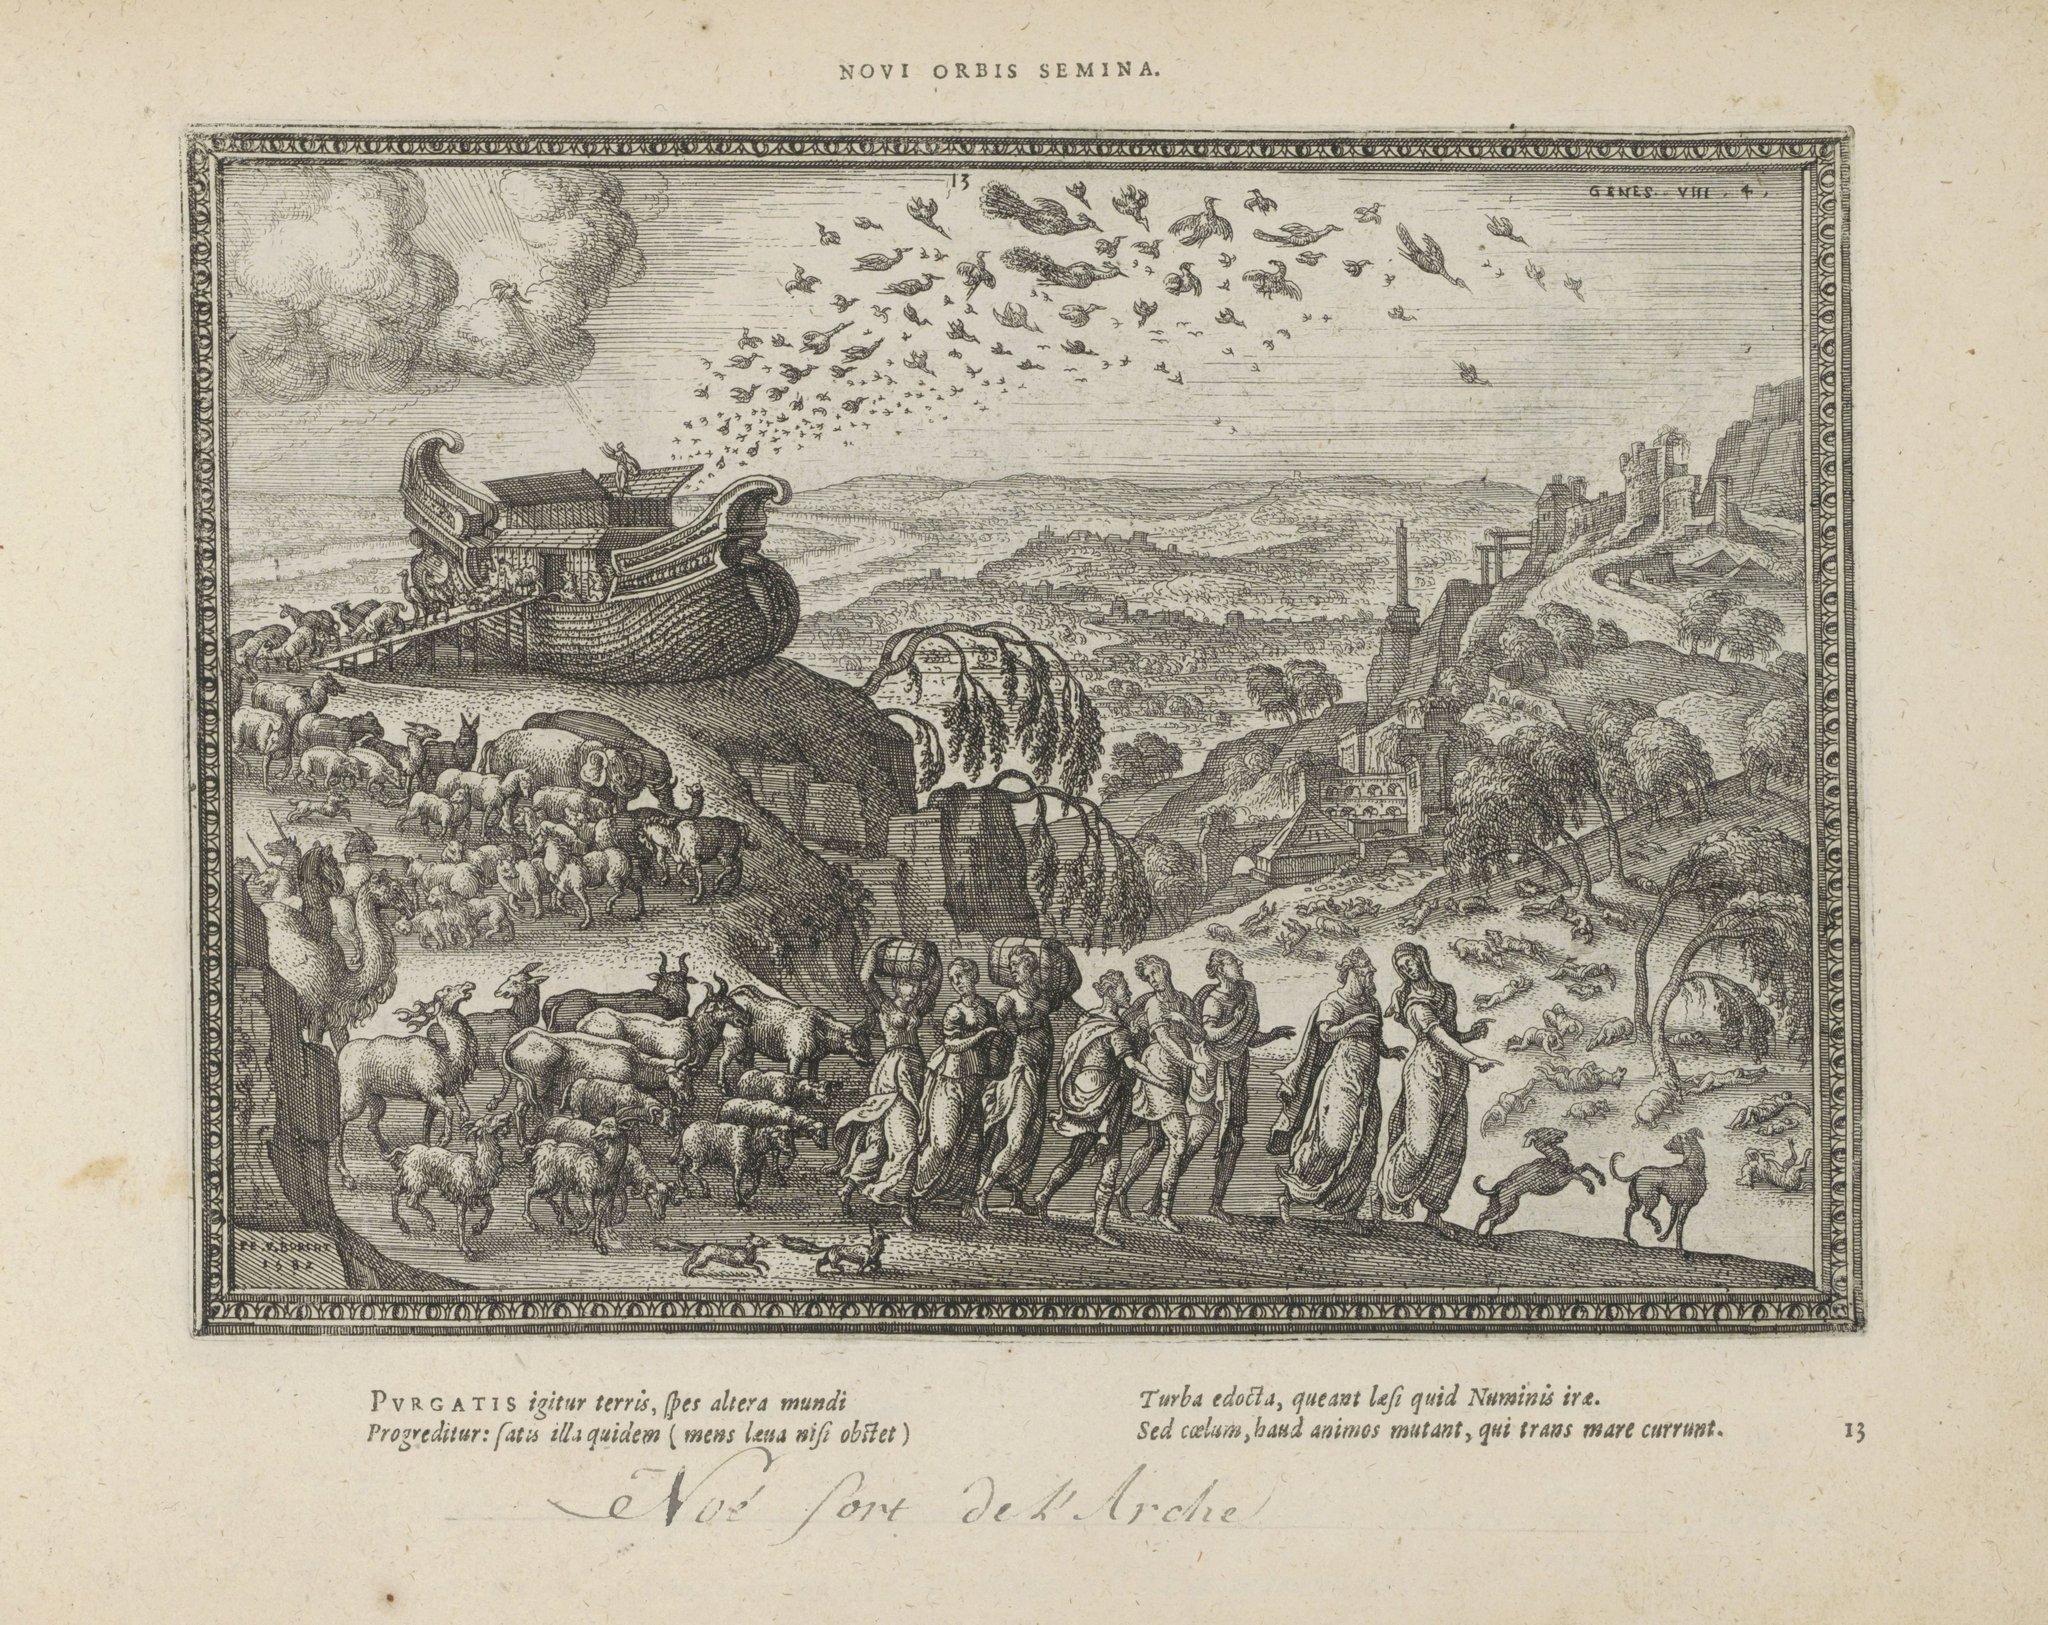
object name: print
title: Emblemata Sacra è praecipuis utriusque testamenti historiis concinnata (Oude Testament)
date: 1582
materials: paper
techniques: etching, letterpress printing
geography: amsterdam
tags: the disembarkation ~ story of noah (genesis 8:18 - 9:17)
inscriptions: inscription: ‘Noé sort de l'Arche’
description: Links de vastgelopen ark op het Araratgebergte. Noach, zijn familie en de dieren verlaten de ark (Gen. 8:4). Op de ark bedankt Noach God voor de redding. Met een motto in het Latijn boven de voorstelling en een vierregelig onderschrift in het Latijn onder de prent. De prent maakt deel uit van een album.